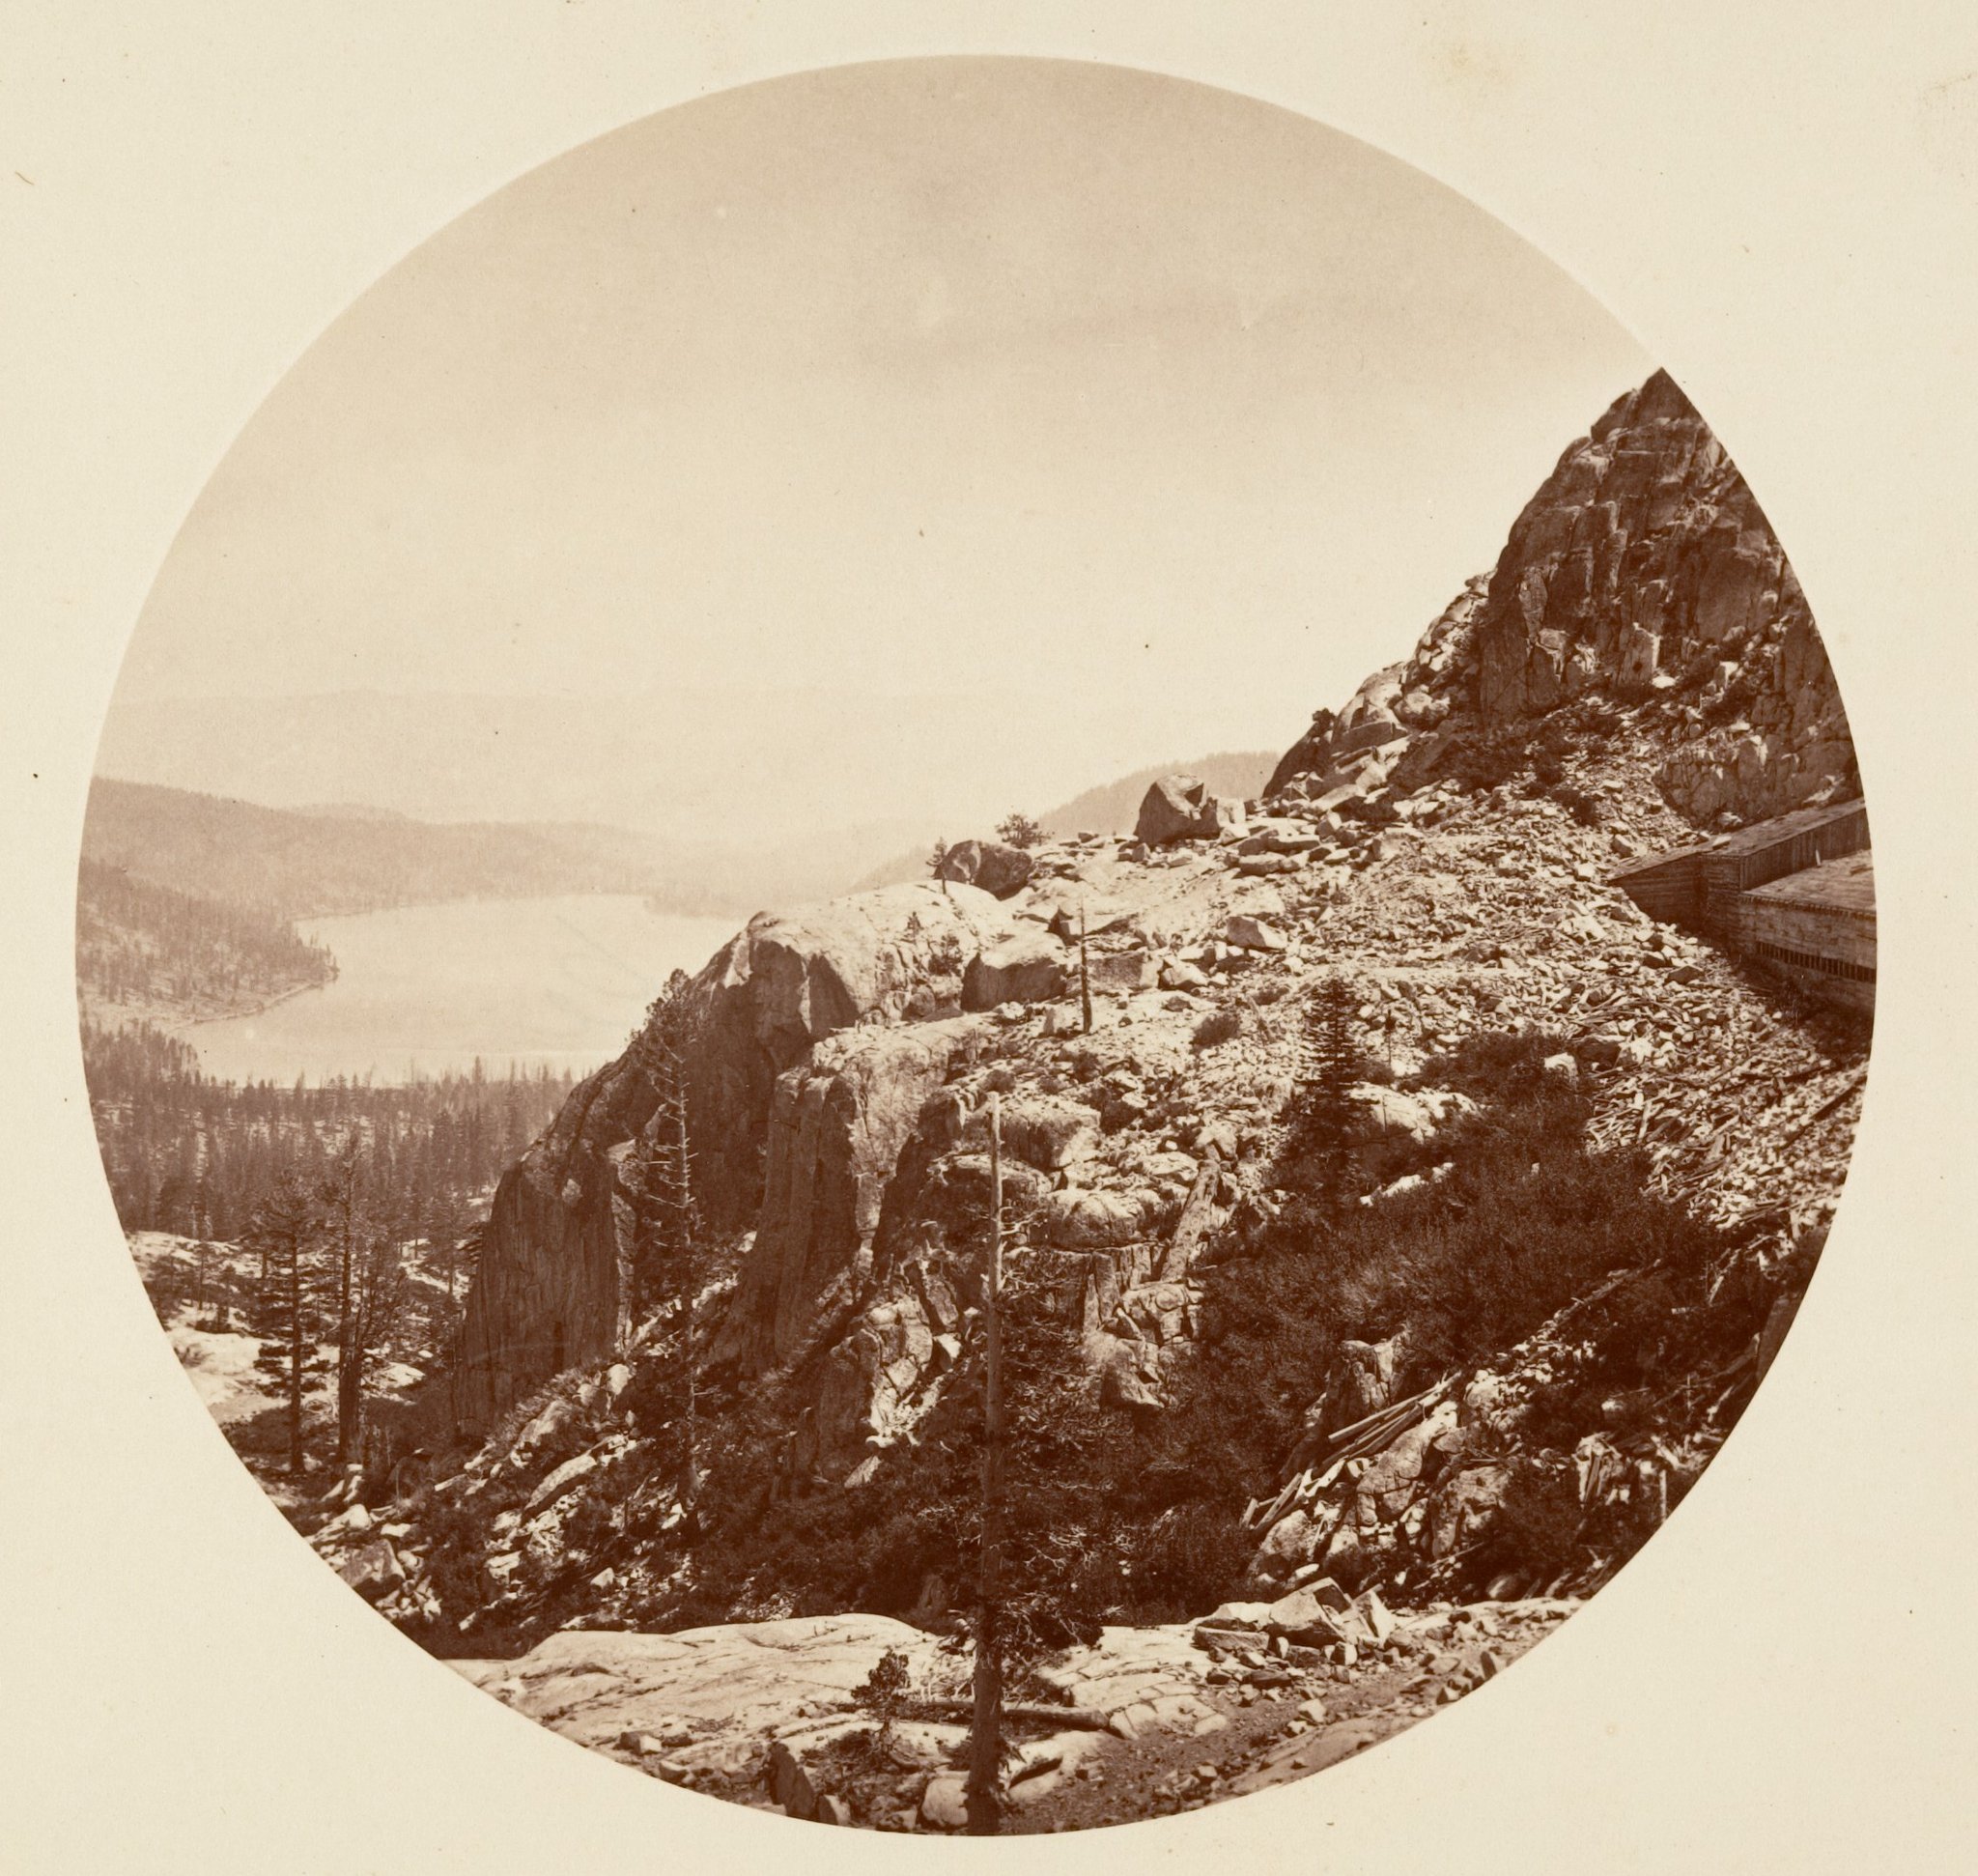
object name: photograph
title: Donner Lake. C. P. R. R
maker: carleton e. watkins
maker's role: artist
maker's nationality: american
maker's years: 1829-1916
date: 1878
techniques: albumen silver print, glass negative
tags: lakes,landscapes